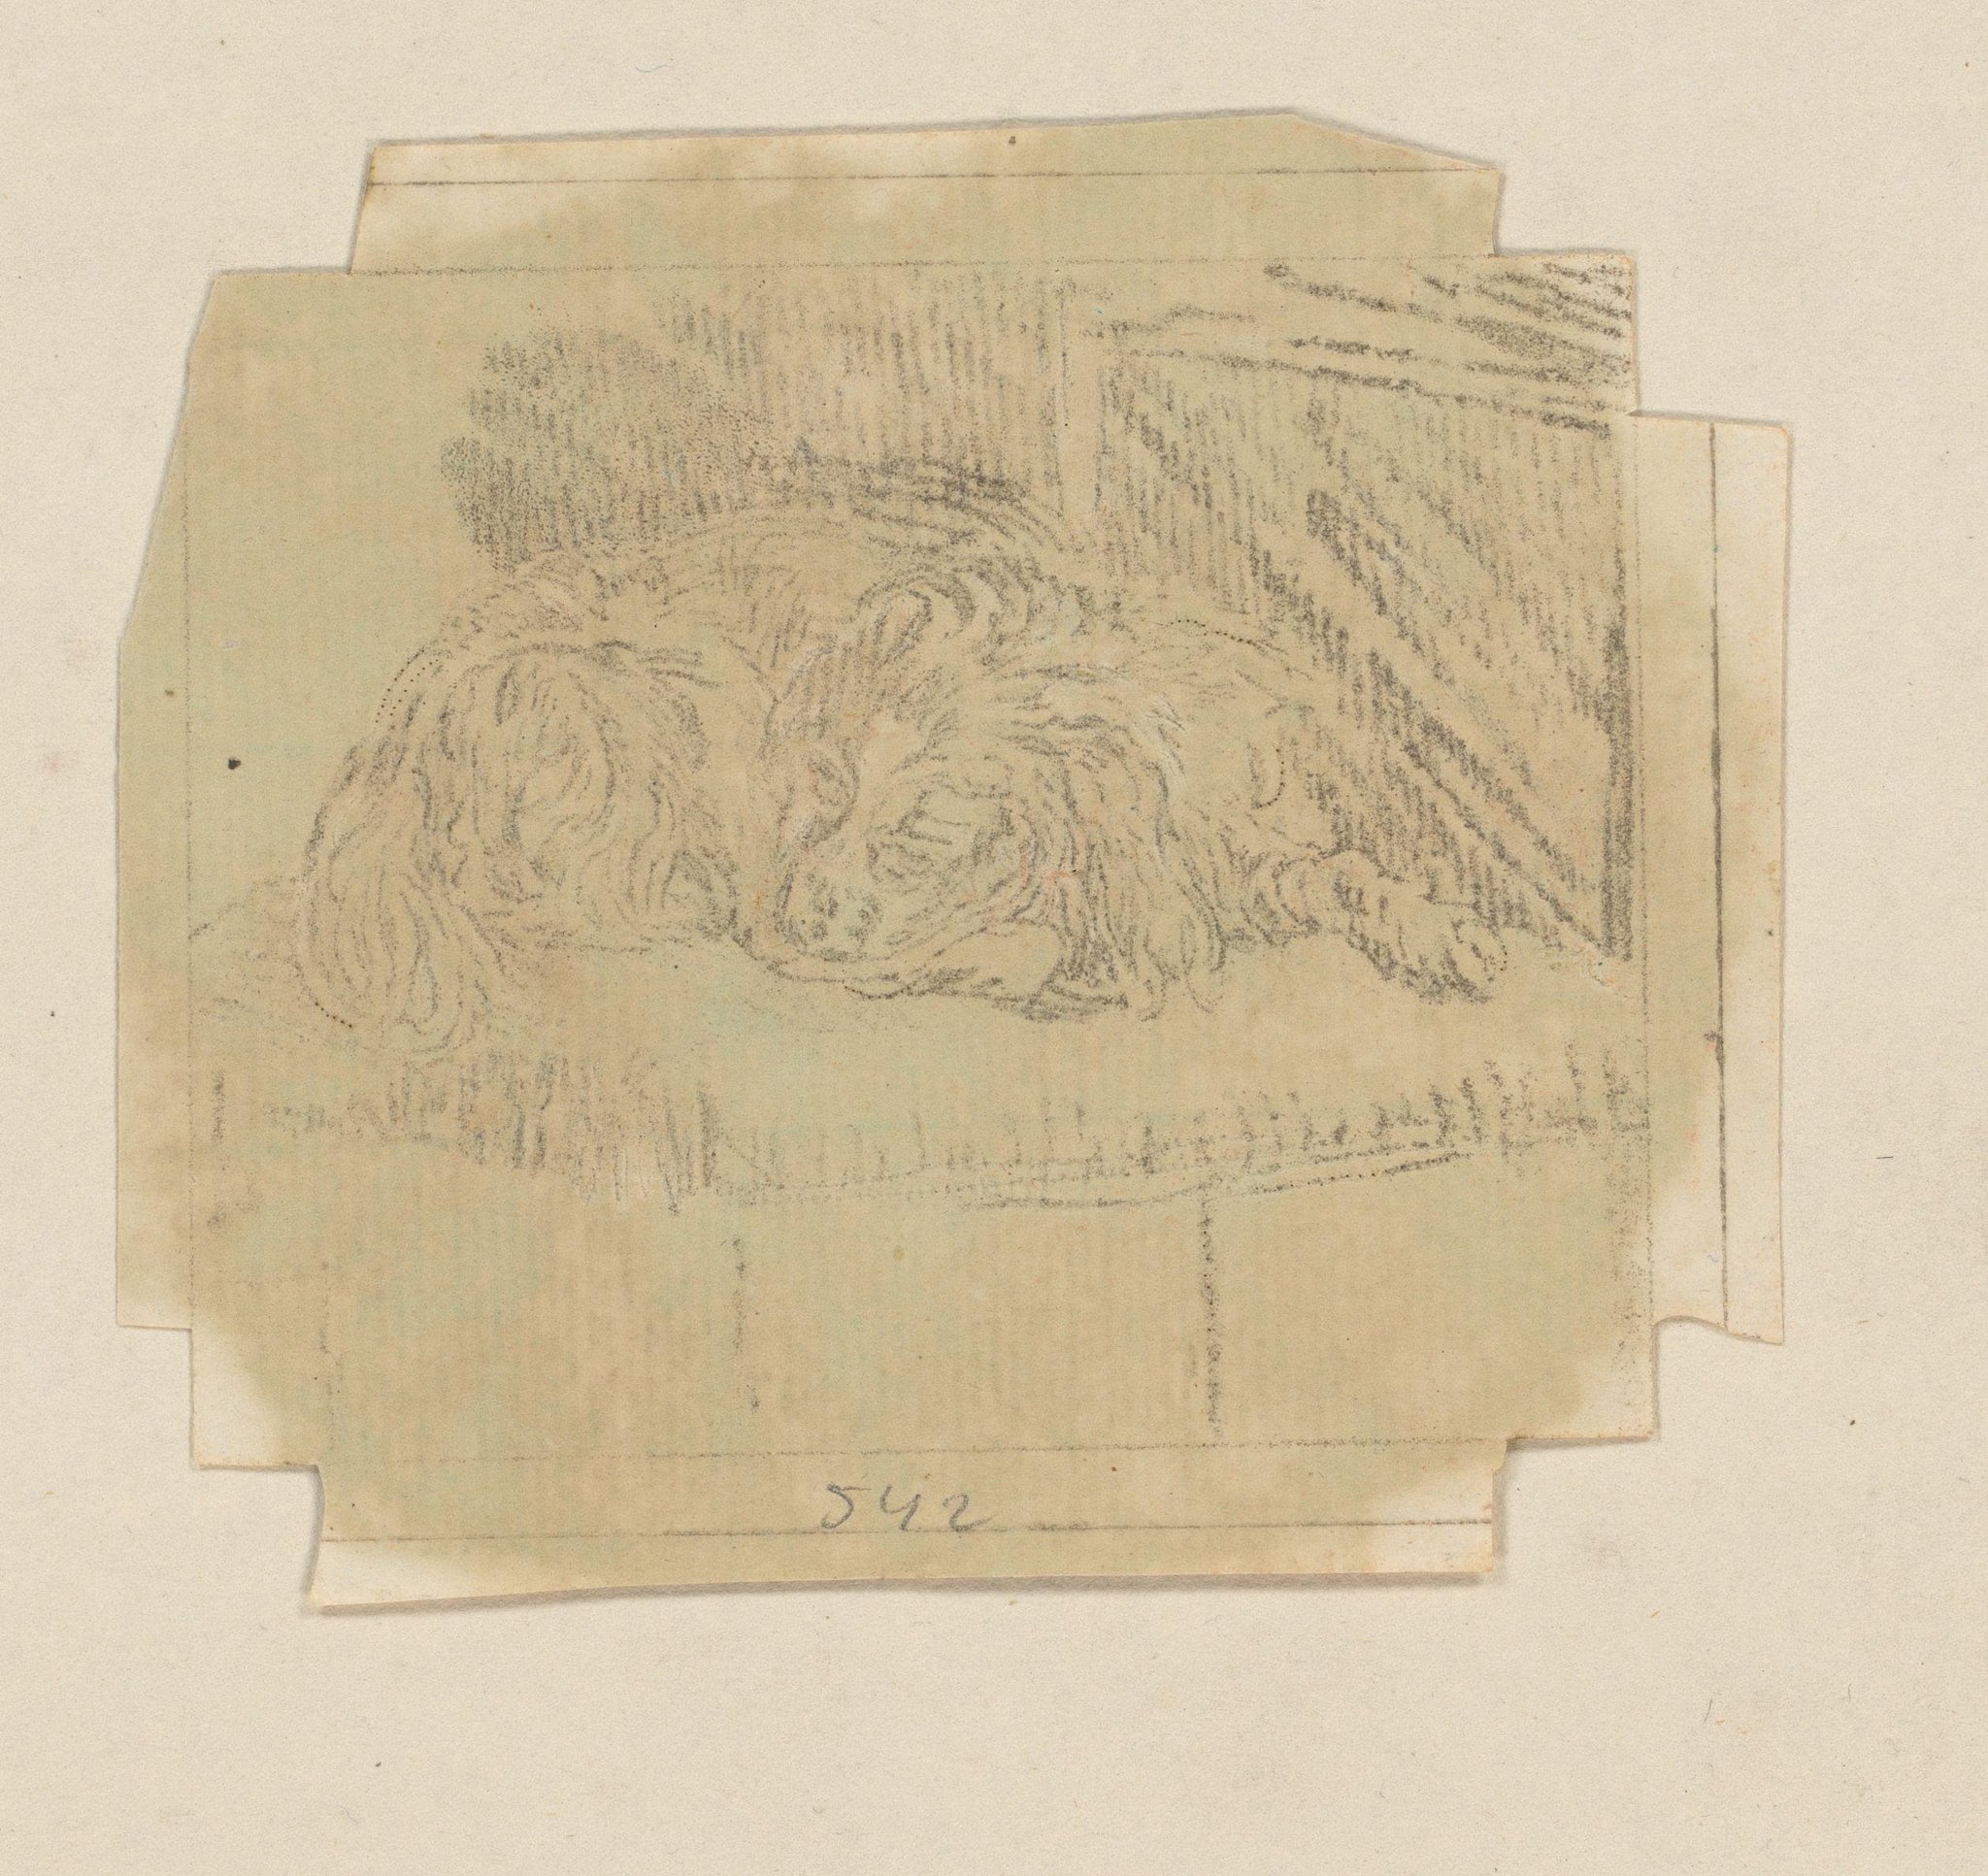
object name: drawing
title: Liggende hond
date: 1777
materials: chalk, paper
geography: amsterdam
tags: dog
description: Over de doordruktekeningen van Ploos van Amstel zie LNP, p. 201.